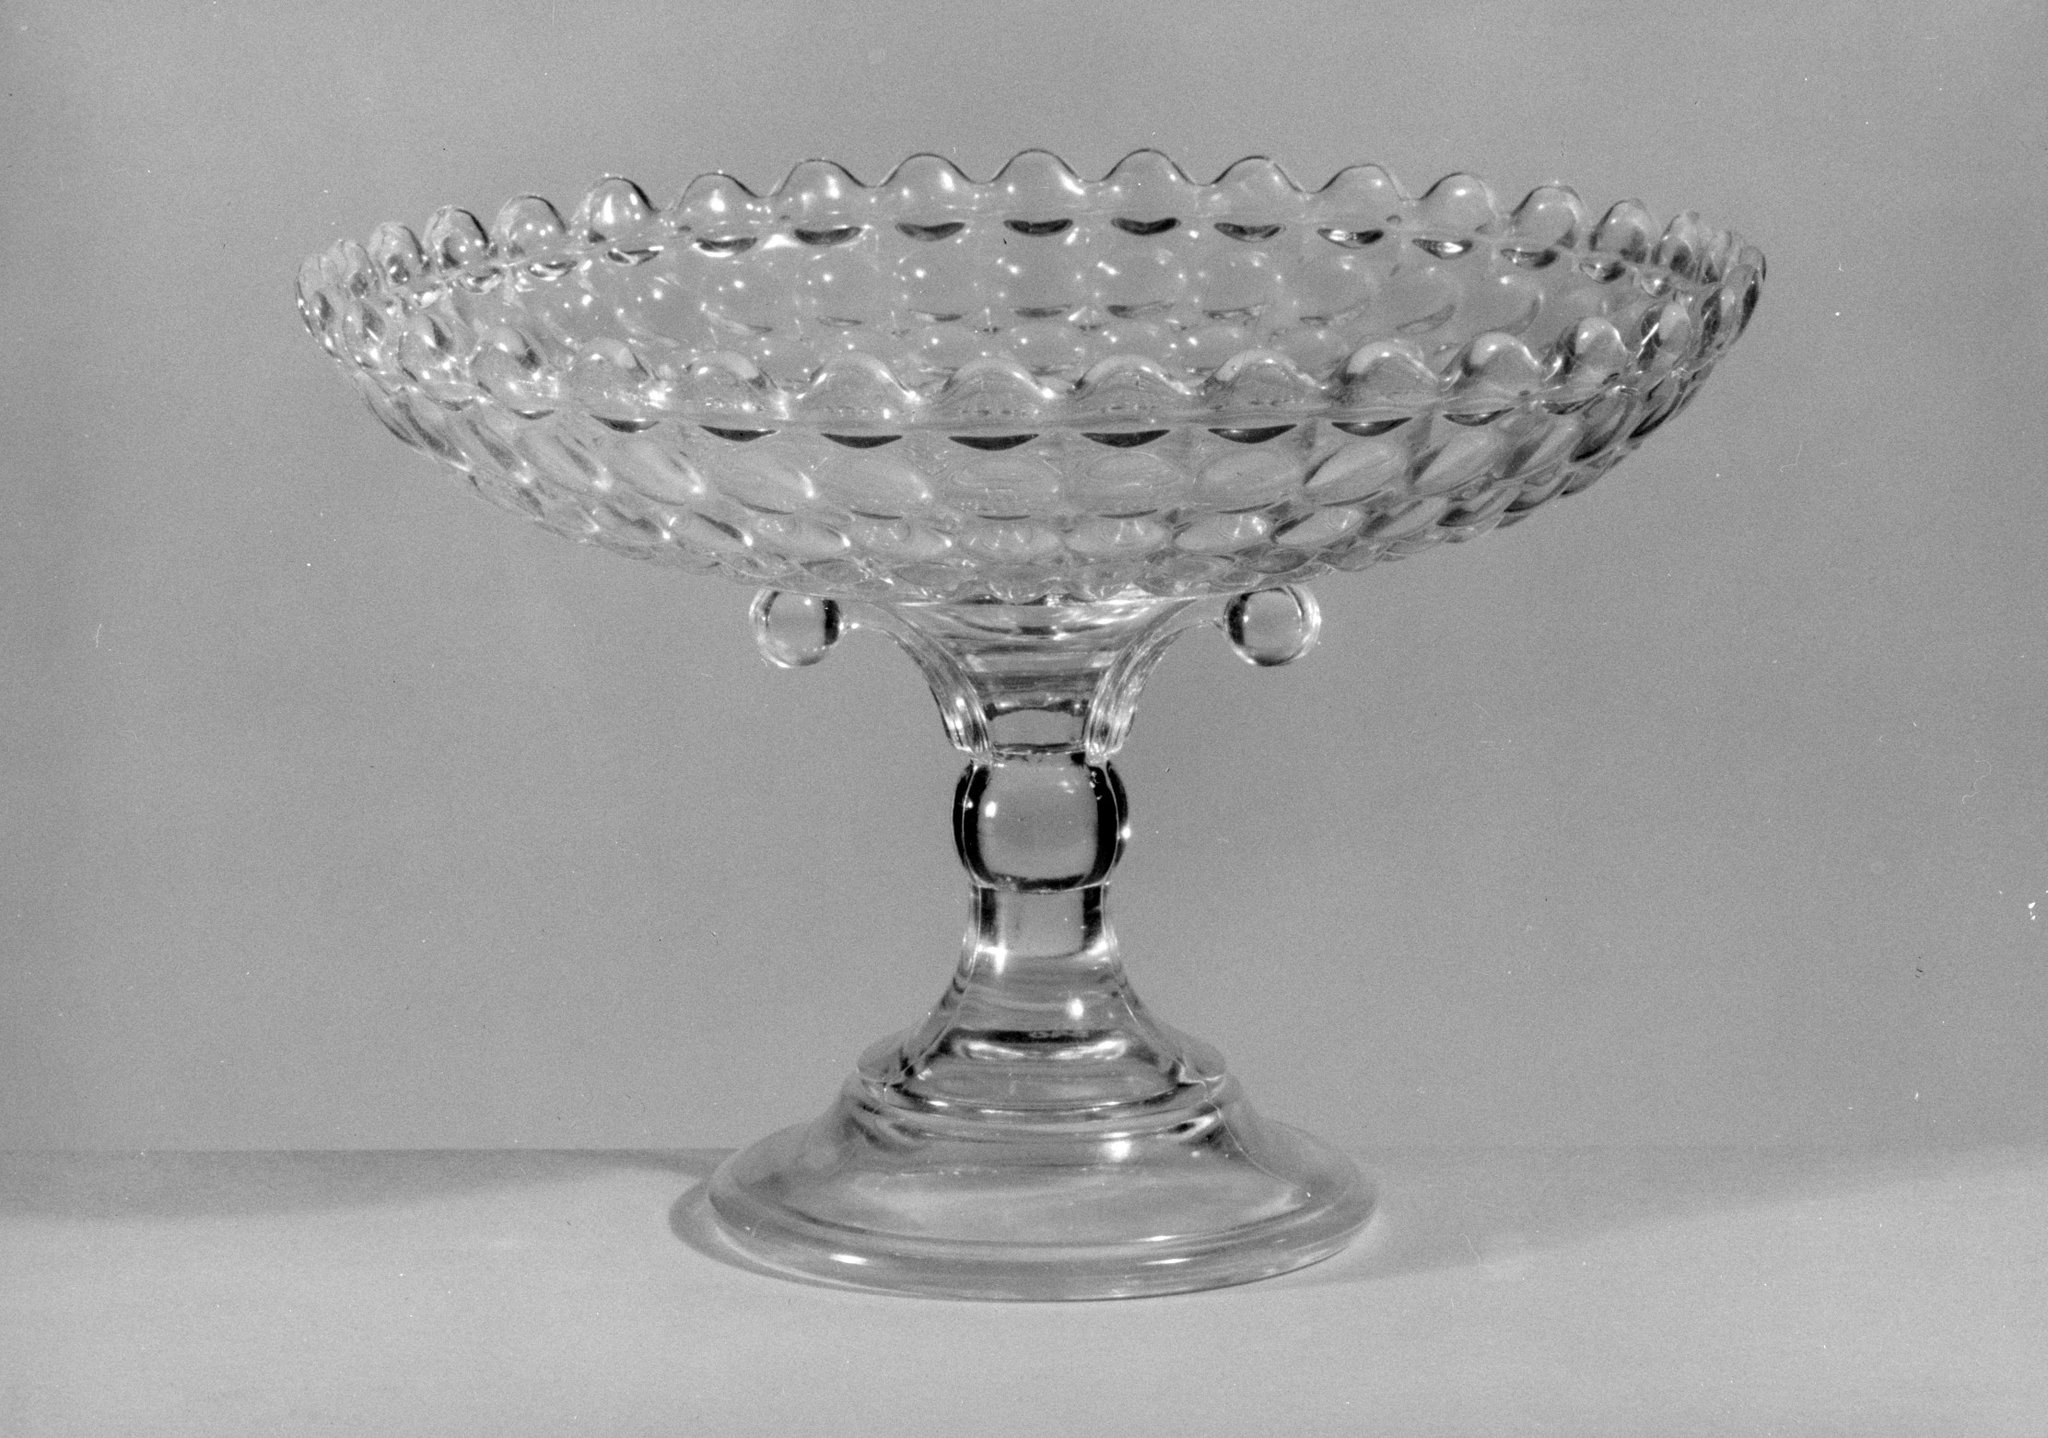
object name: compote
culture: american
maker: adams and company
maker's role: maker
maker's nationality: american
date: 1870-1890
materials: glass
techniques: pressed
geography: united states